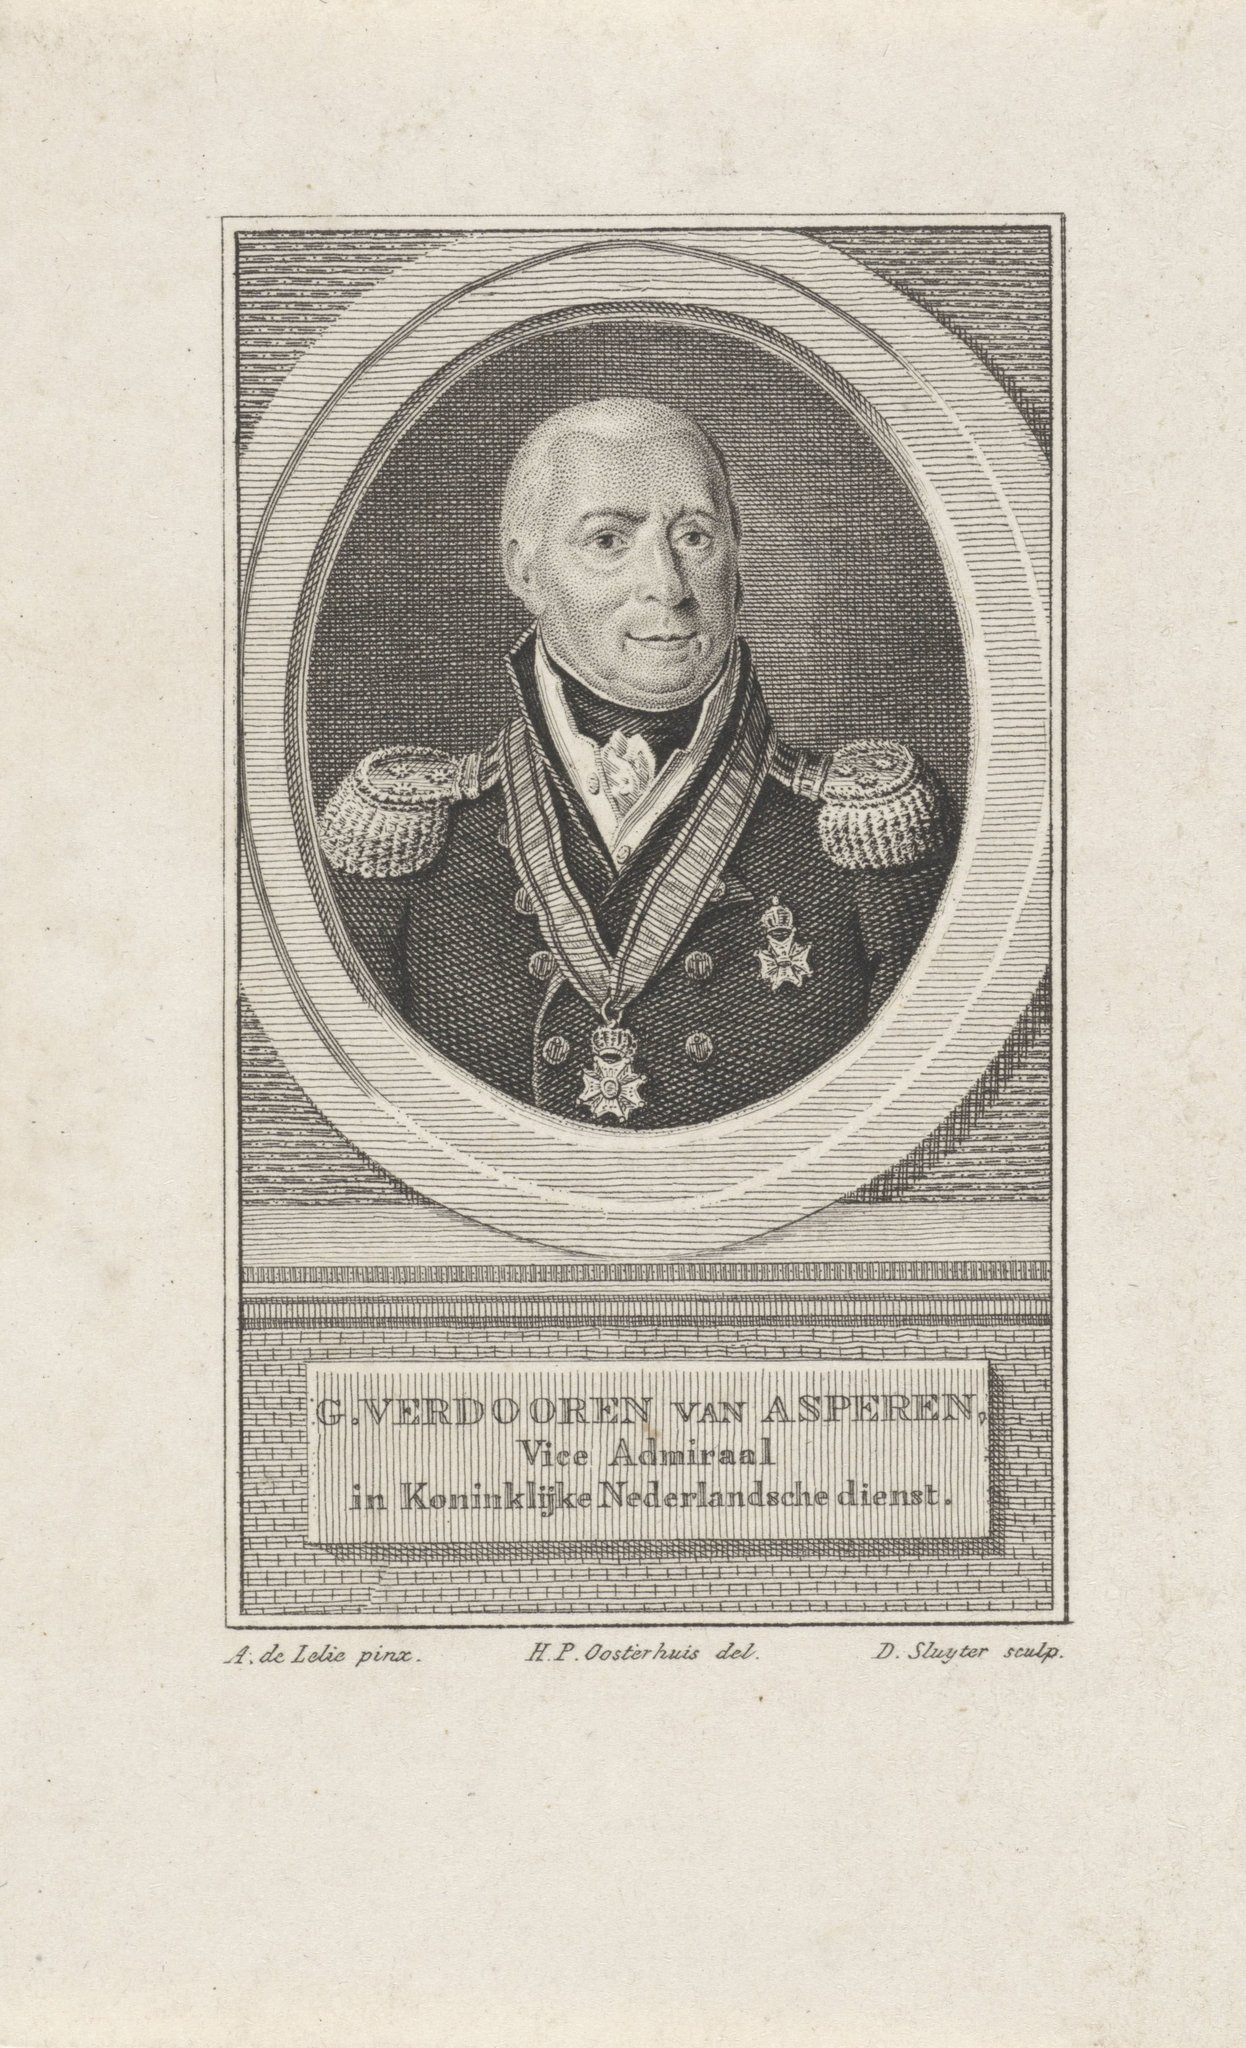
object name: print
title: Portret van Gerrit Verdooren van Asperen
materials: paper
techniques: engraving, etching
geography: amsterdam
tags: oost-souburg, gerrit verdooren van asperen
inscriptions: collector's mark: Lugt 2228